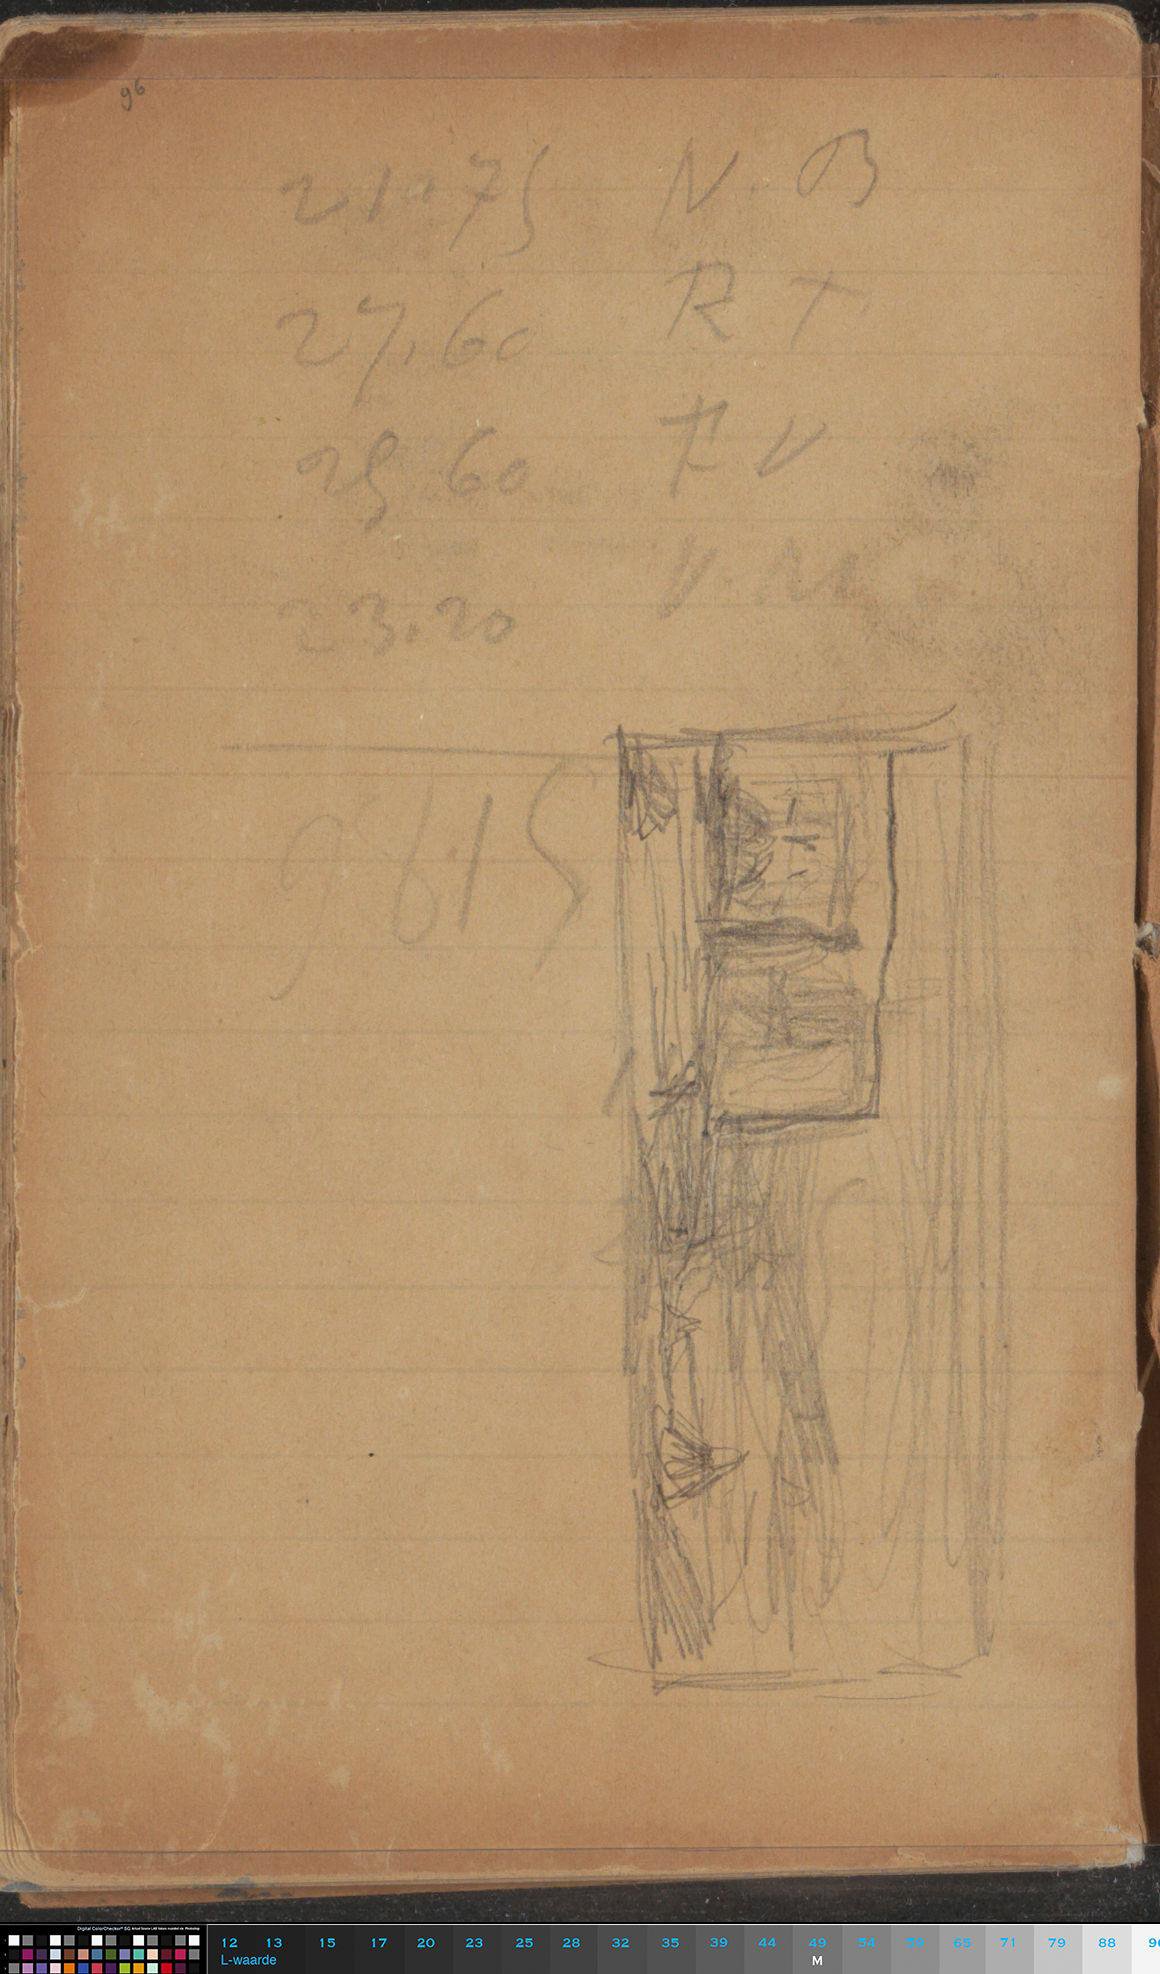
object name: sketchbook leaf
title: Woestijnlandschap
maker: marius bauer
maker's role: draughtsman, print maker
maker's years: 1867-1932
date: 1894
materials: chalk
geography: egypt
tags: desert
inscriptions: annotation: ‘[...]’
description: Pagina 96 uit een schetsboek met 48 bladen.